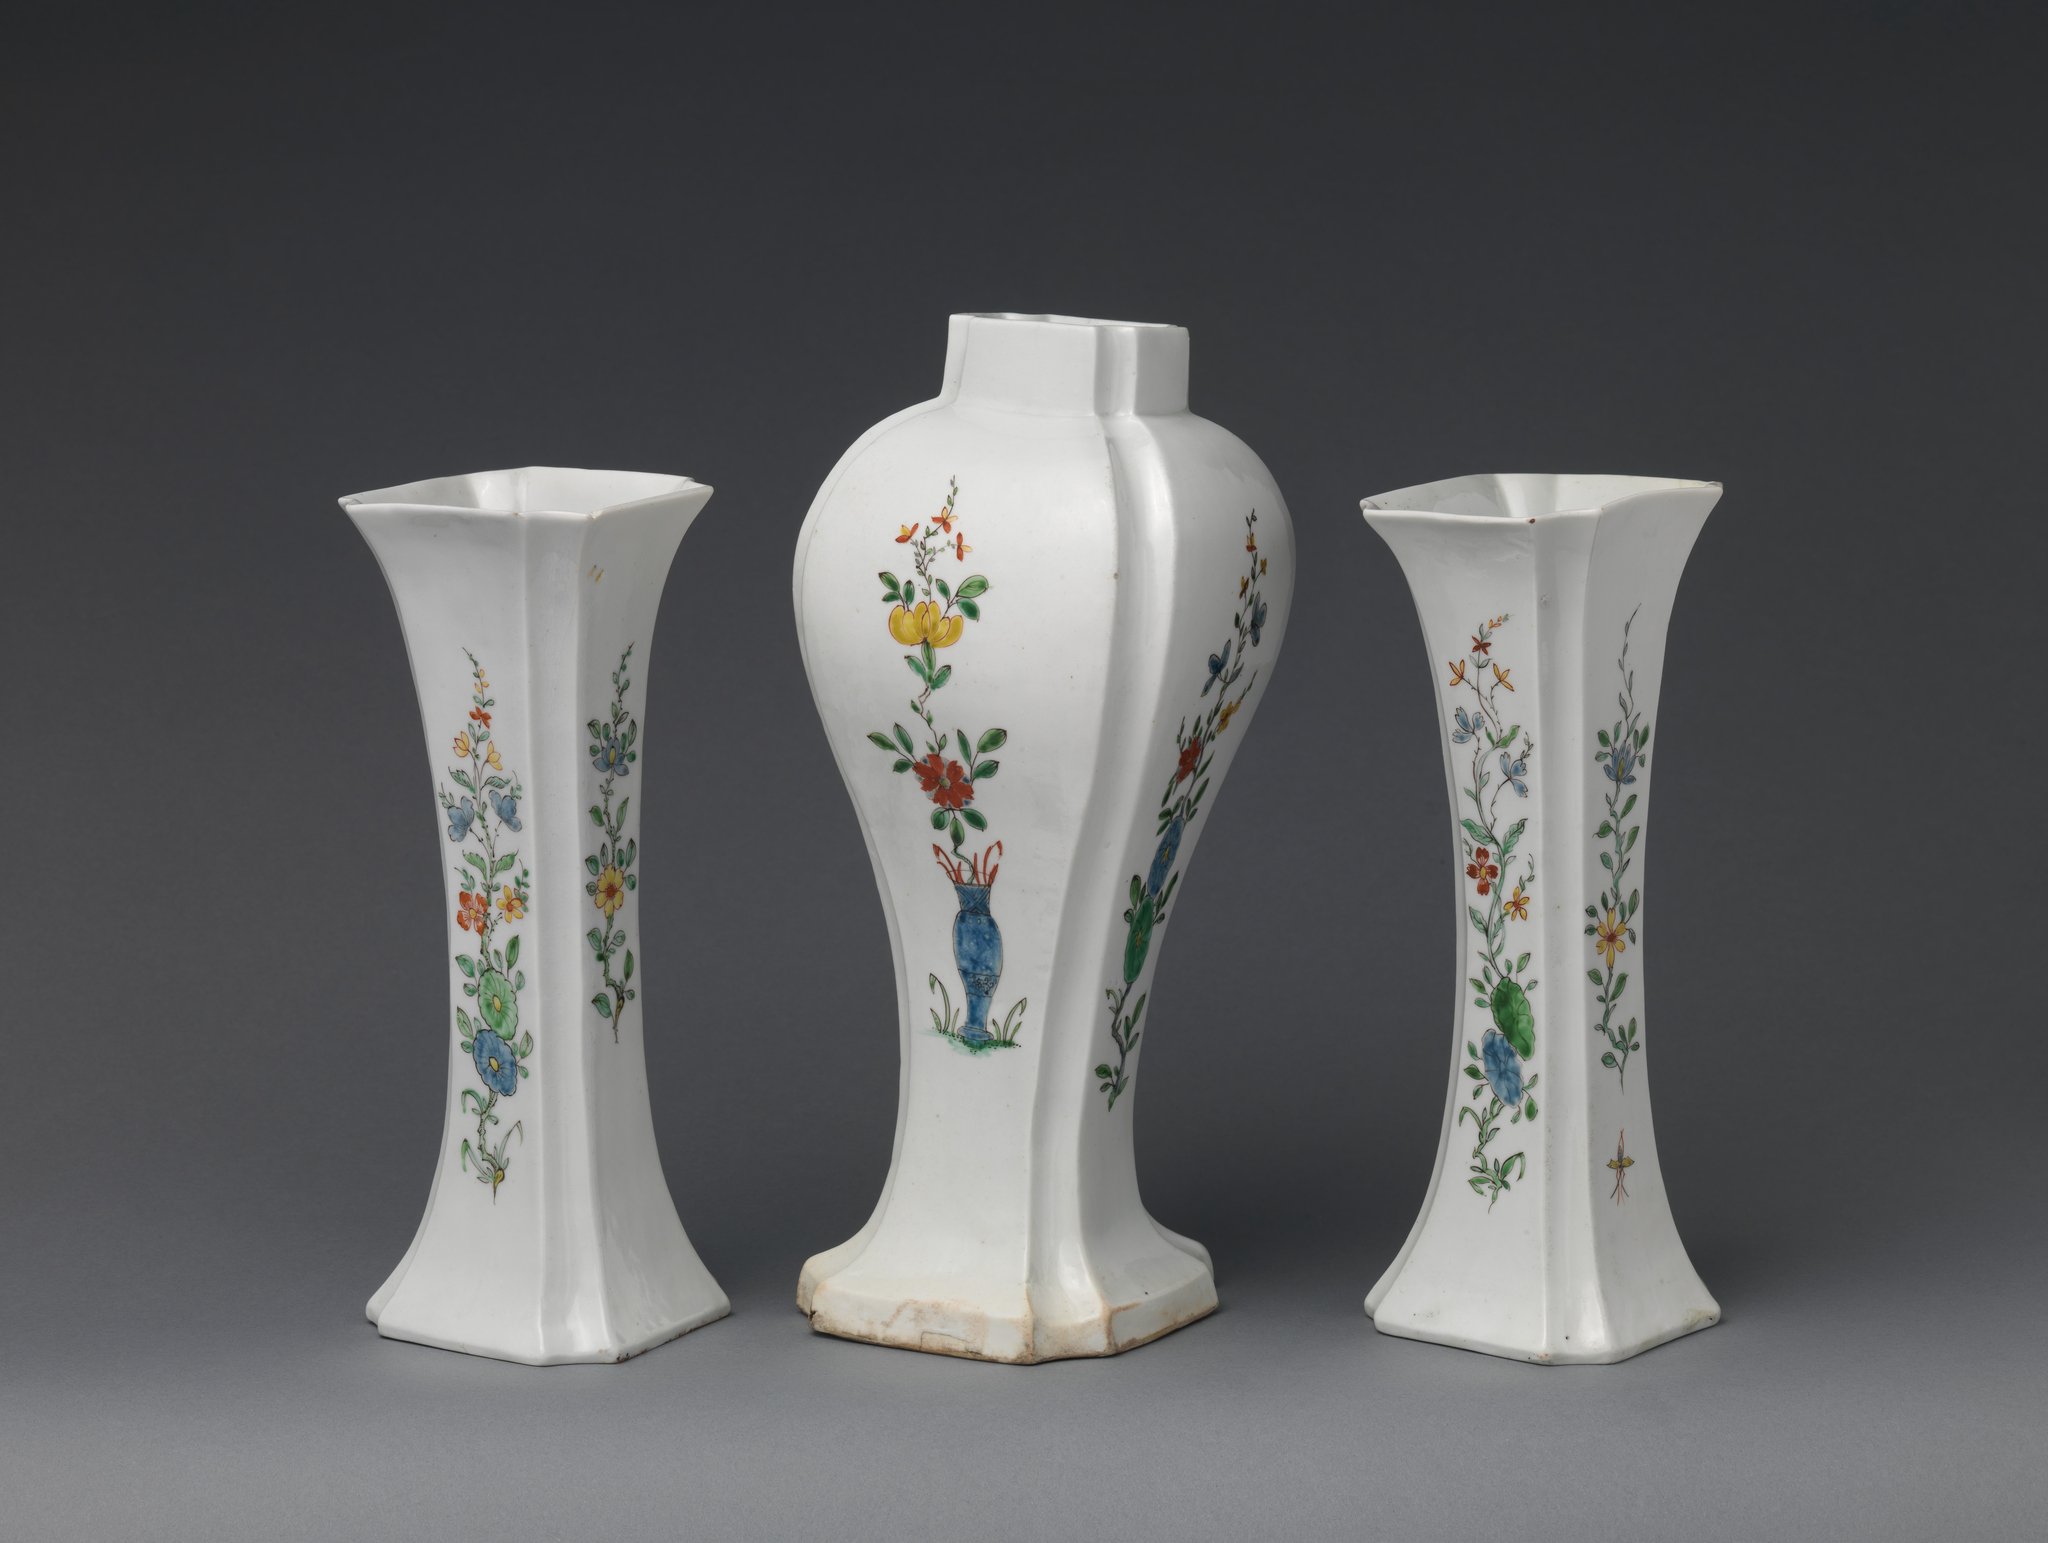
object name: garniture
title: Garniture of three vases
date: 1752-1753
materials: enamel, soft paste porcelain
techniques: polychrome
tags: flowers